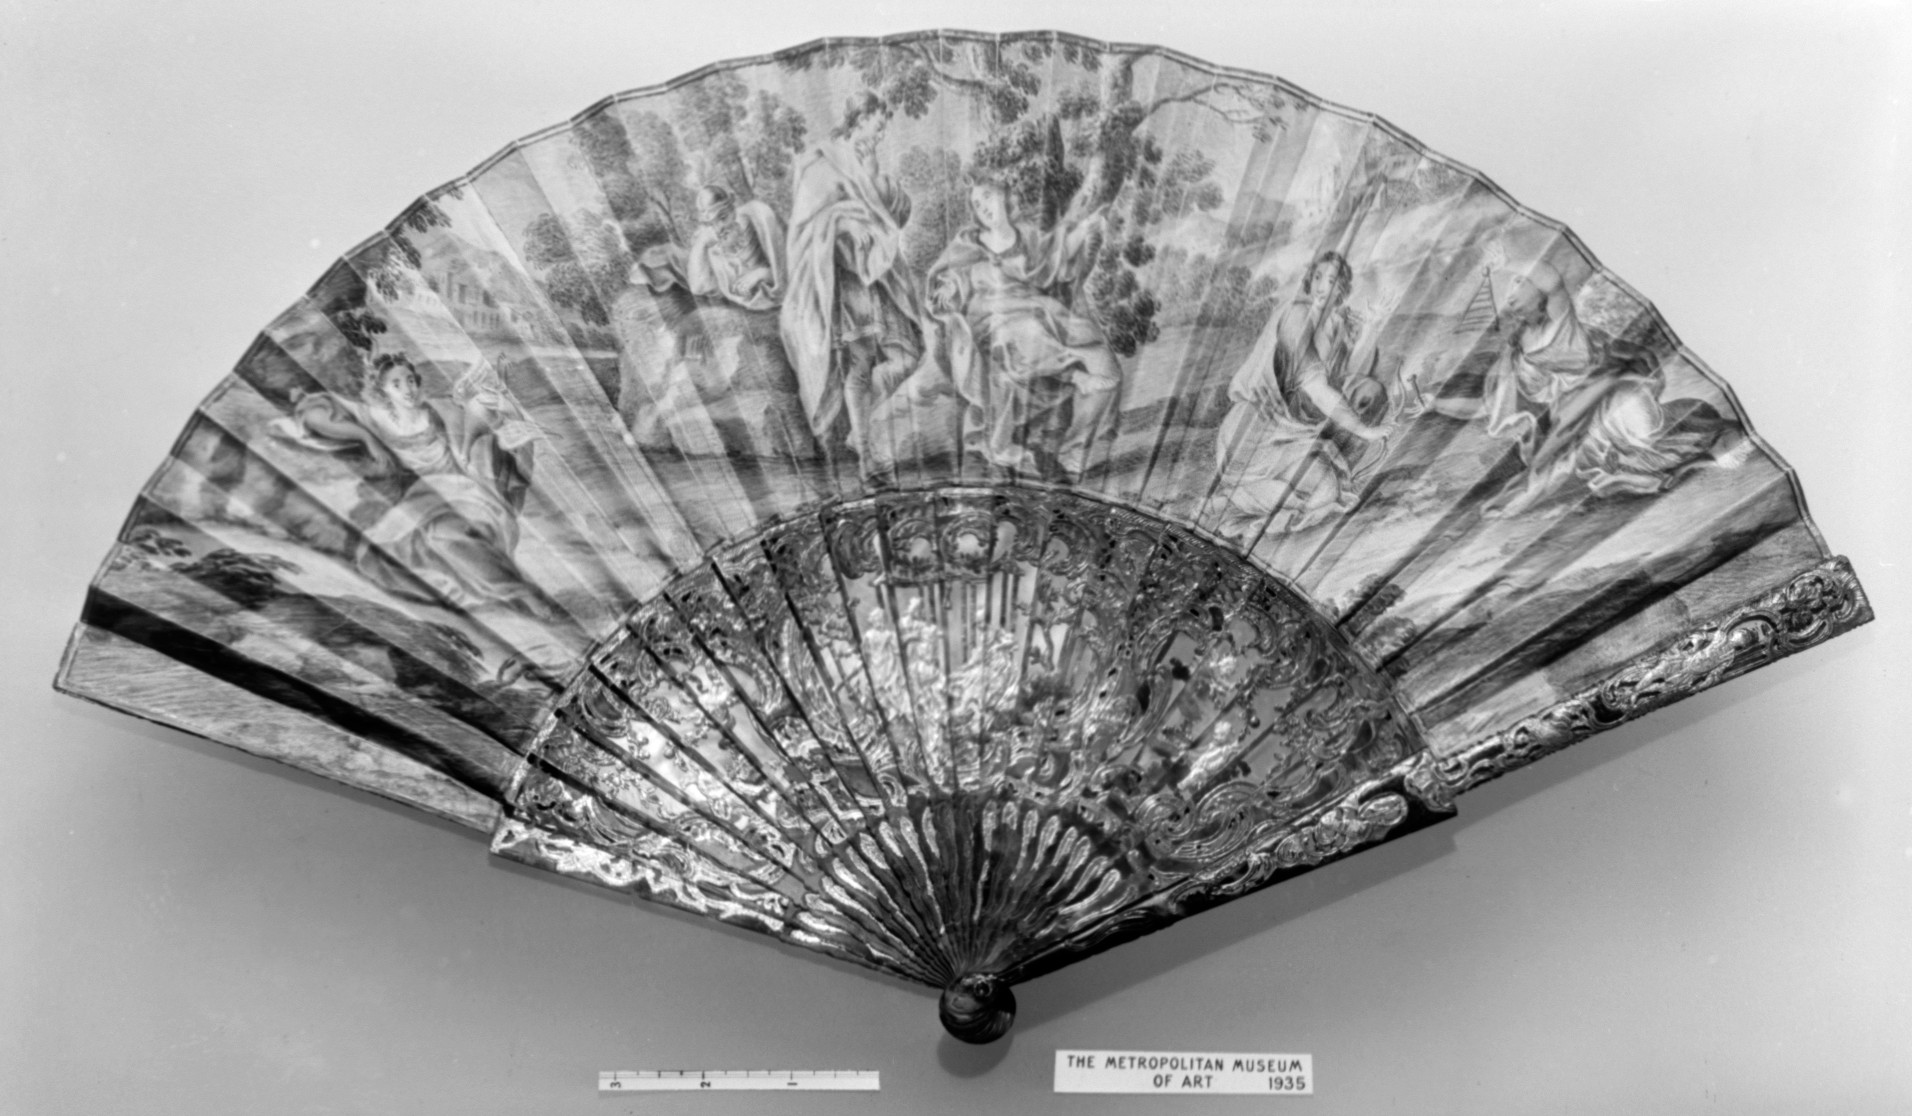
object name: fan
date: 1734-1766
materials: gold leaf, mother of pearl, silver, skin, shell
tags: men,women